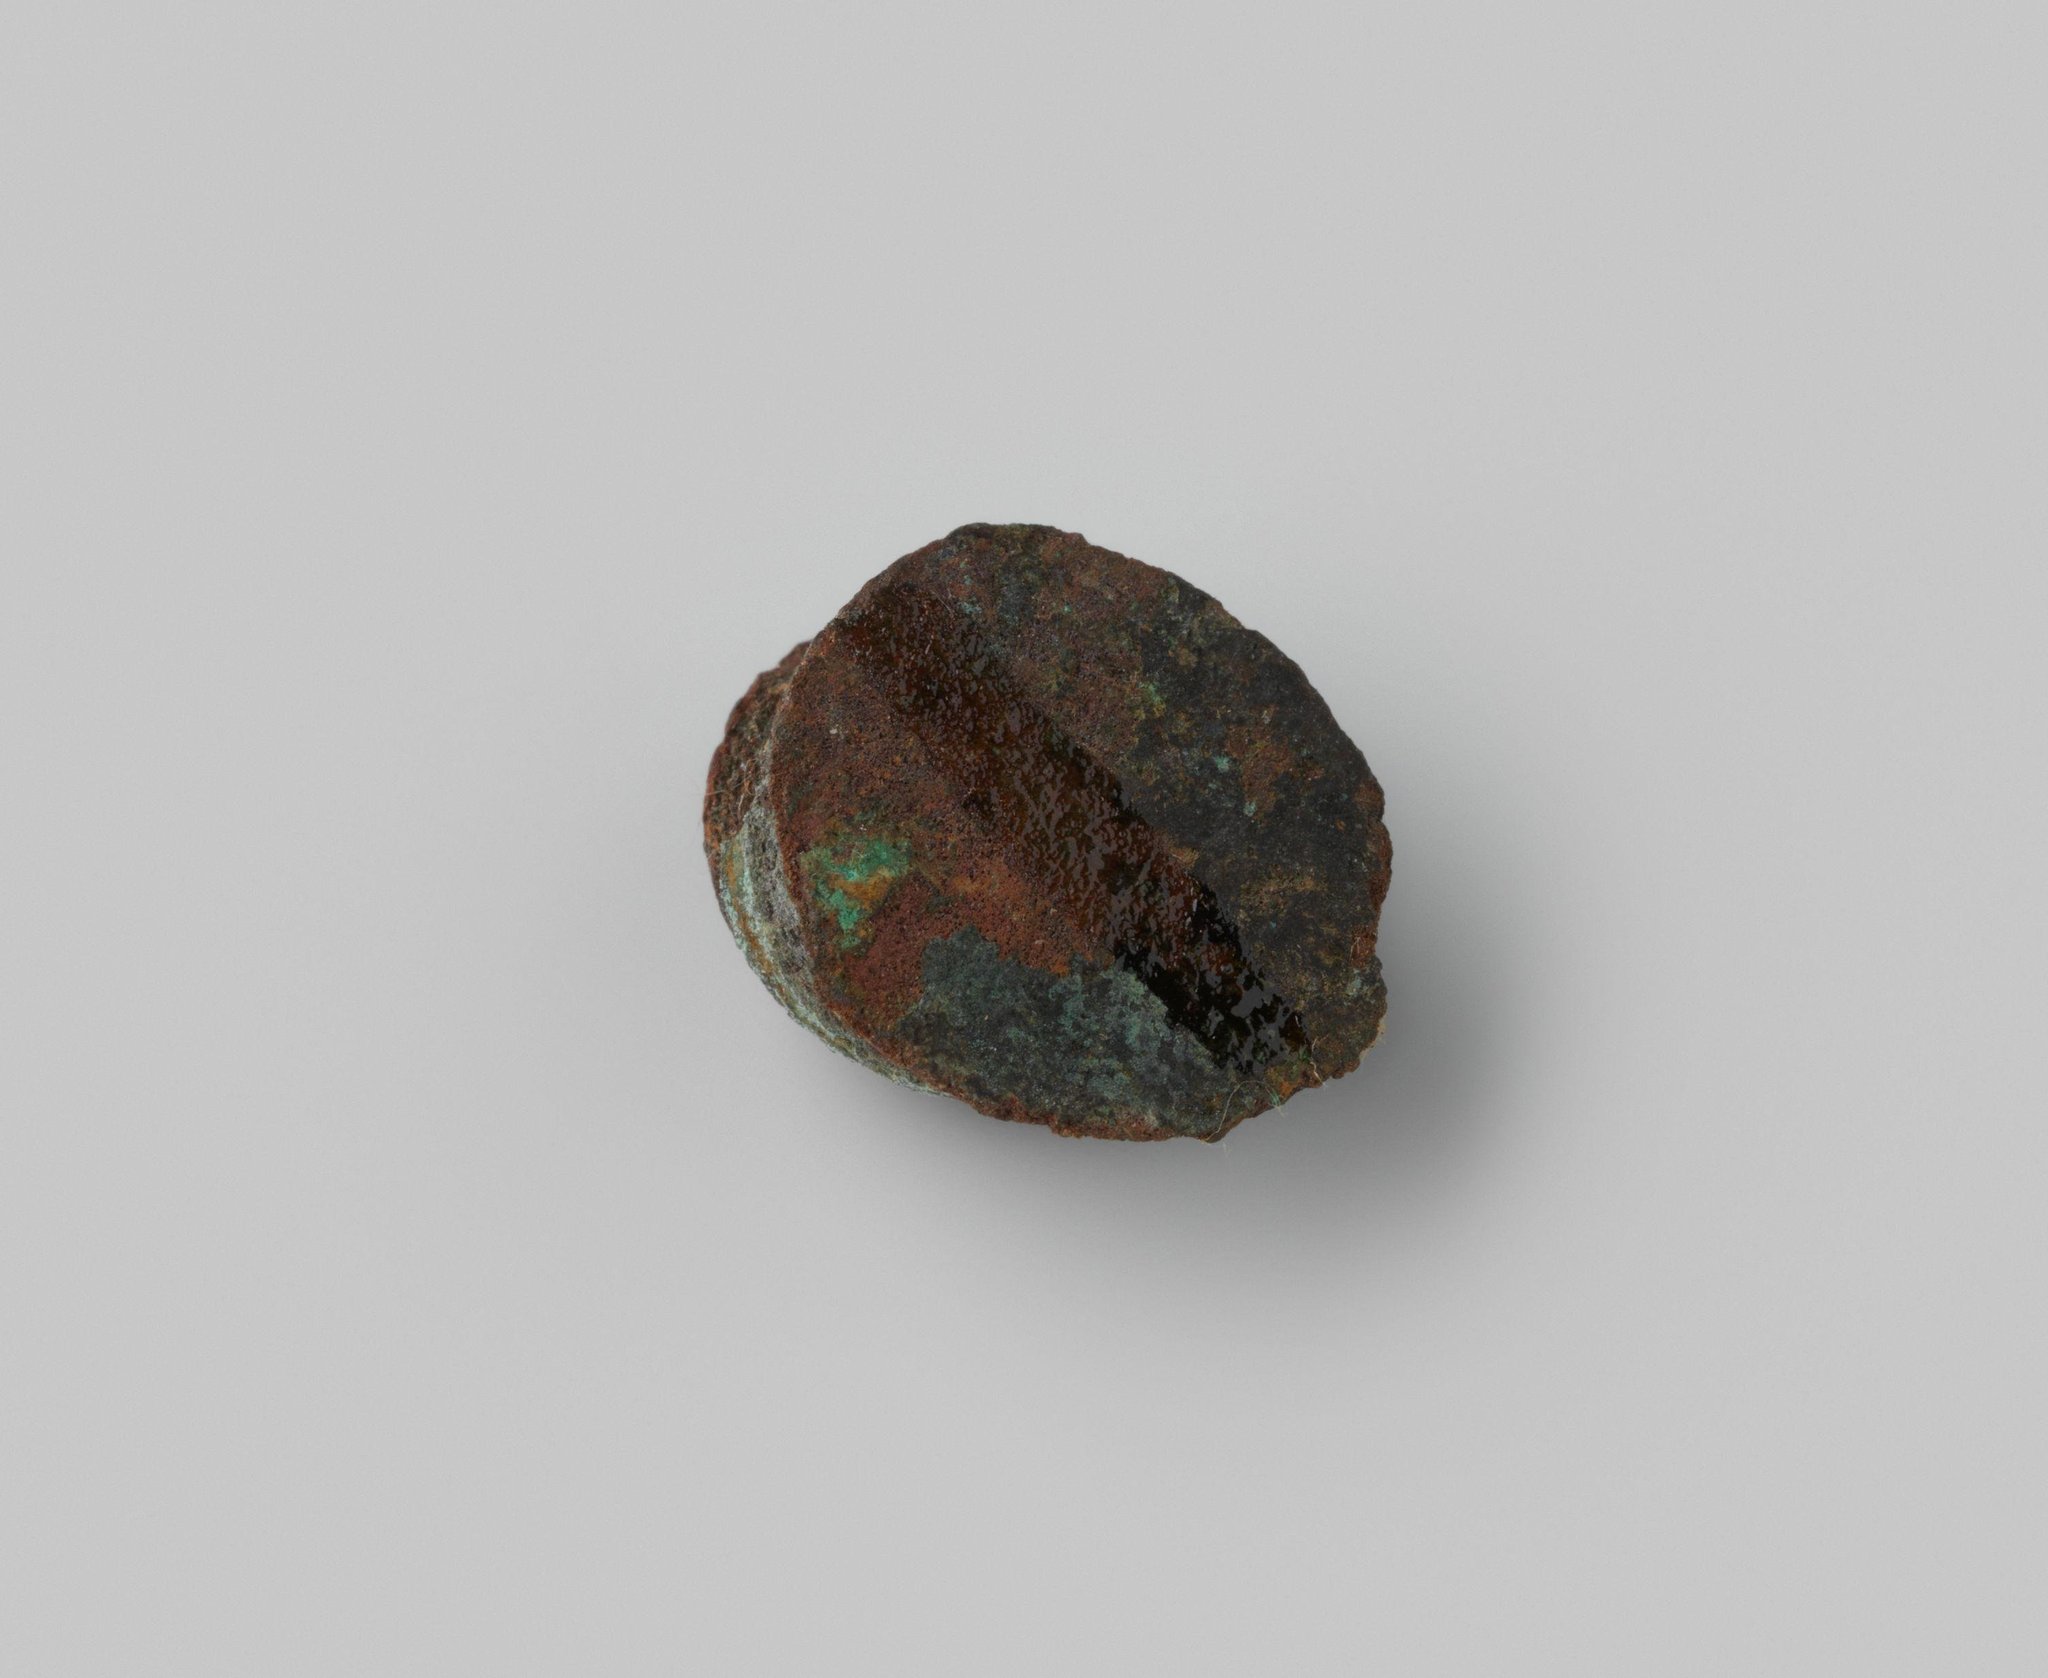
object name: rivet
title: Klinknagel afkomstig uit het wrak van de Oost-Indiëvaarder Hollandia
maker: Anonymous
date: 1700-1743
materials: copper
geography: netherlands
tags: verenigde oostindische compagnie, hollandia (schip)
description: Rivets; fragm of shaft, eroded, sim. 80H1067.